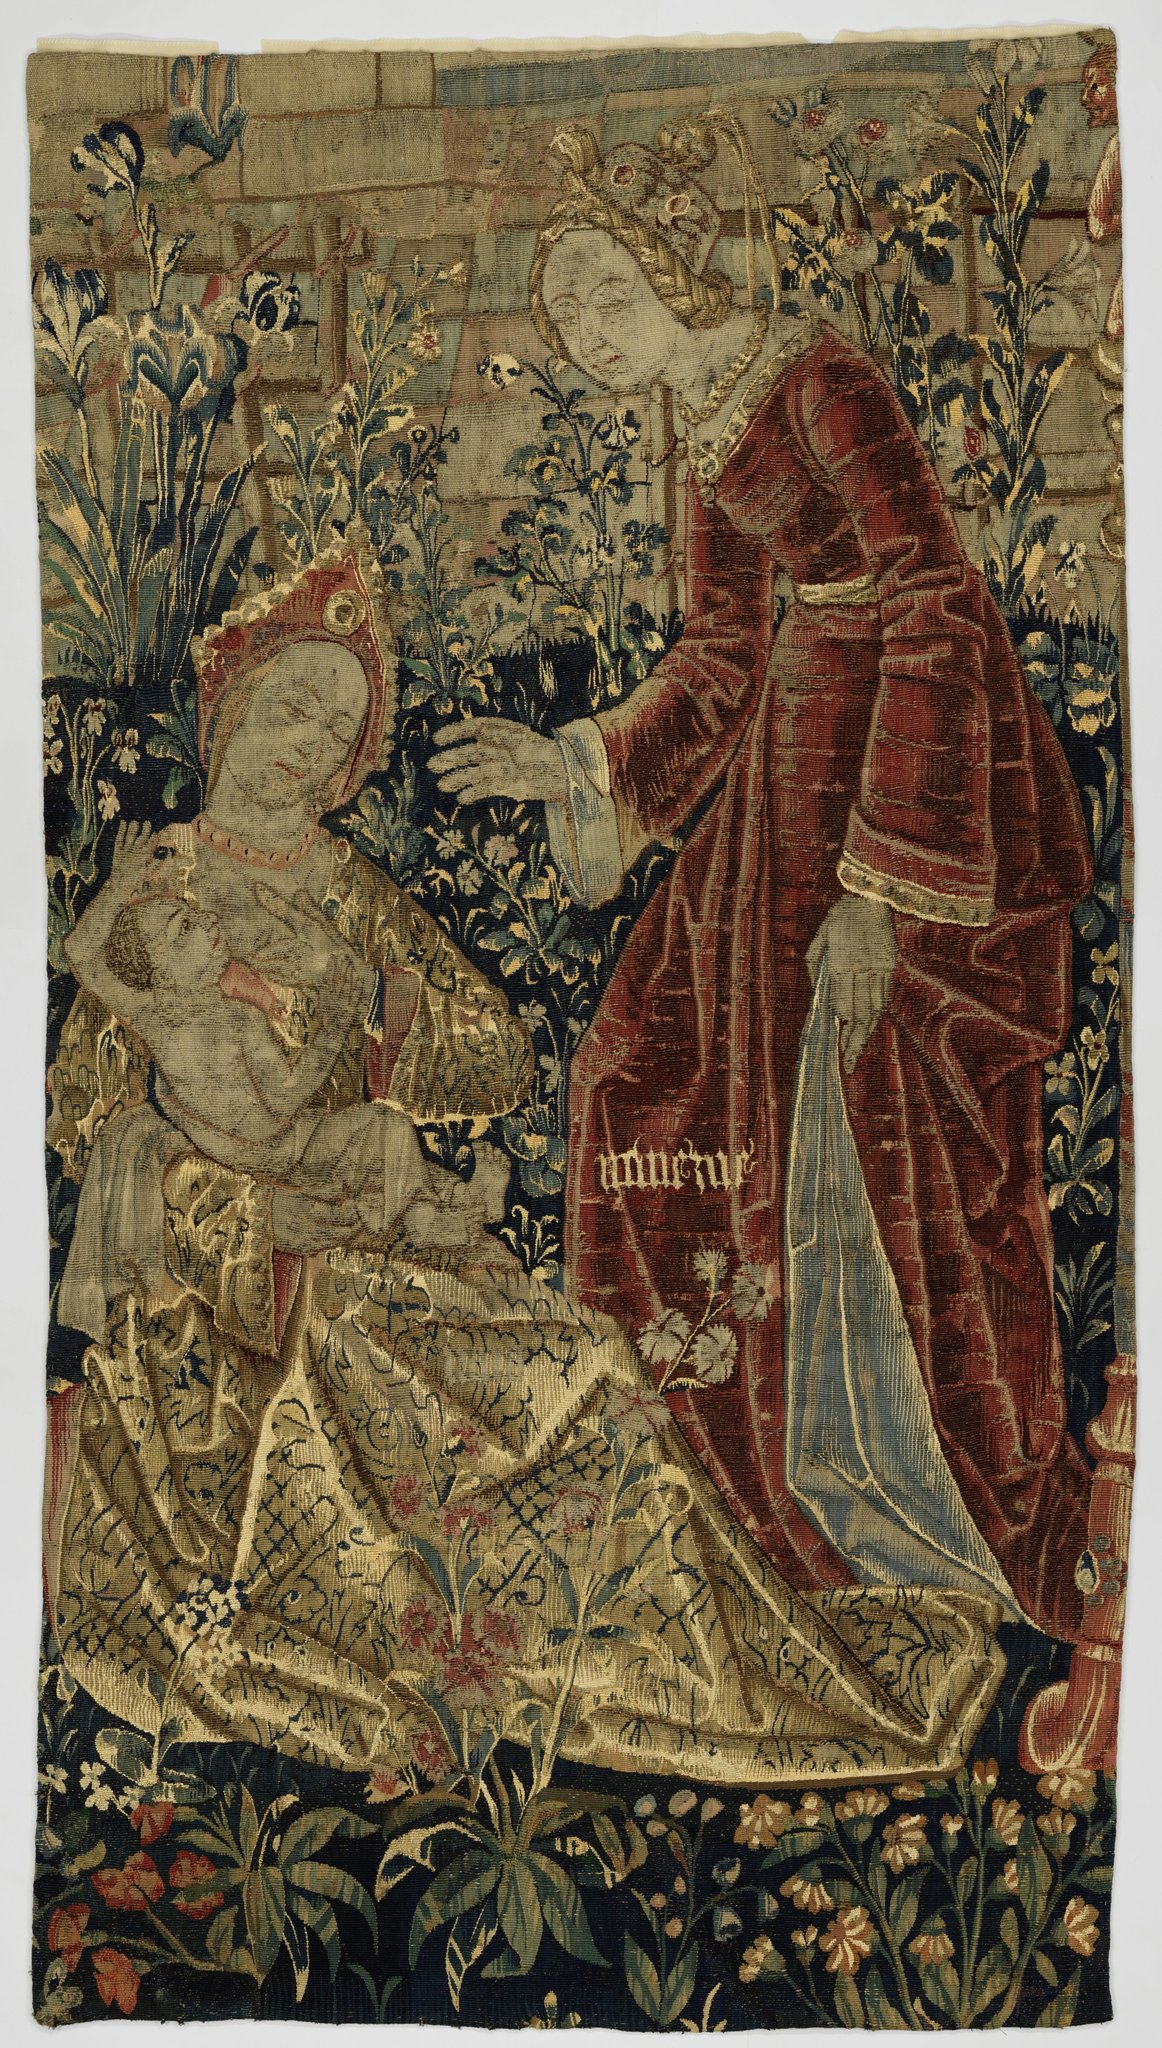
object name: tapestry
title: Juno voedt Hercules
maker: Anonymous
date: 1485-1505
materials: silk, wool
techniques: tapestry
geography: southern netherlands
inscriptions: : ‘MINERUE’, : ‘IUNO’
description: Tapestry (fragment). The Childhood of Hercules: Hercules Suckled by a Nurse. Wool, silk. Tournai or Brussels, c. 1485 - 1500.